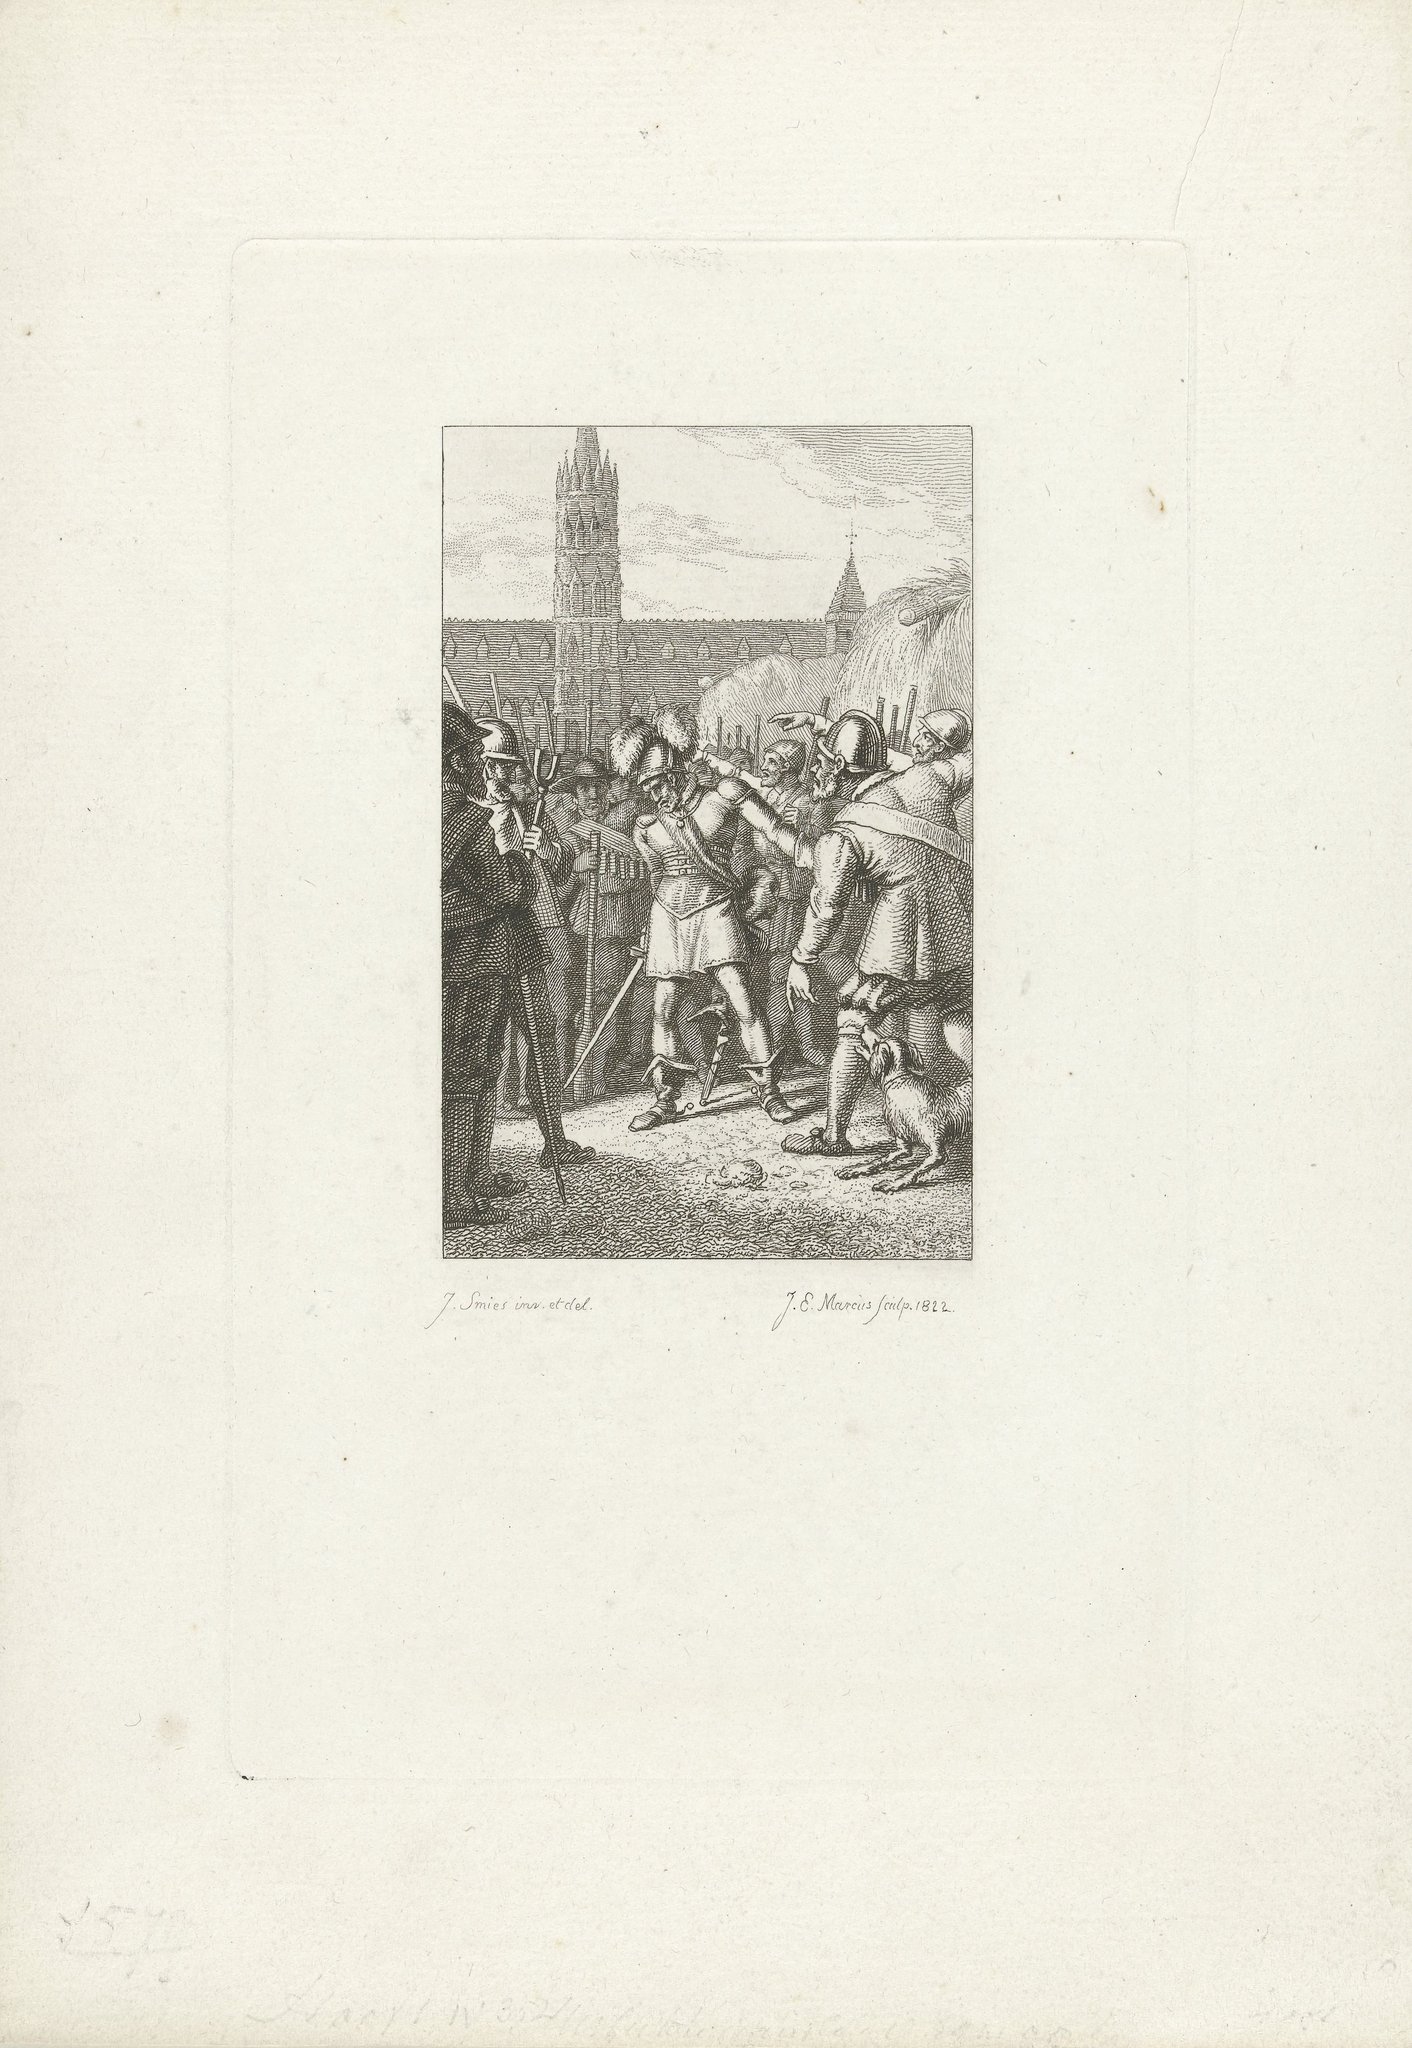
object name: print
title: Mislukte aanslag van Egmond op Brussel, 1579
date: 1822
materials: paper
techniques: etching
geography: netherlands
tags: staatsman, kolonel, filips van egmond, grote markt, tachtigjarige oorlog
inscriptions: date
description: Mislukte aanslag op Brussel door Filips van Egmond, 1579. Groep soldaten en boeren houden de graaf gevangen op de Grote Markt en wijzen hem op de plaats voor het stadhuis waar zijn vader Lamoraal onthoofd werd.